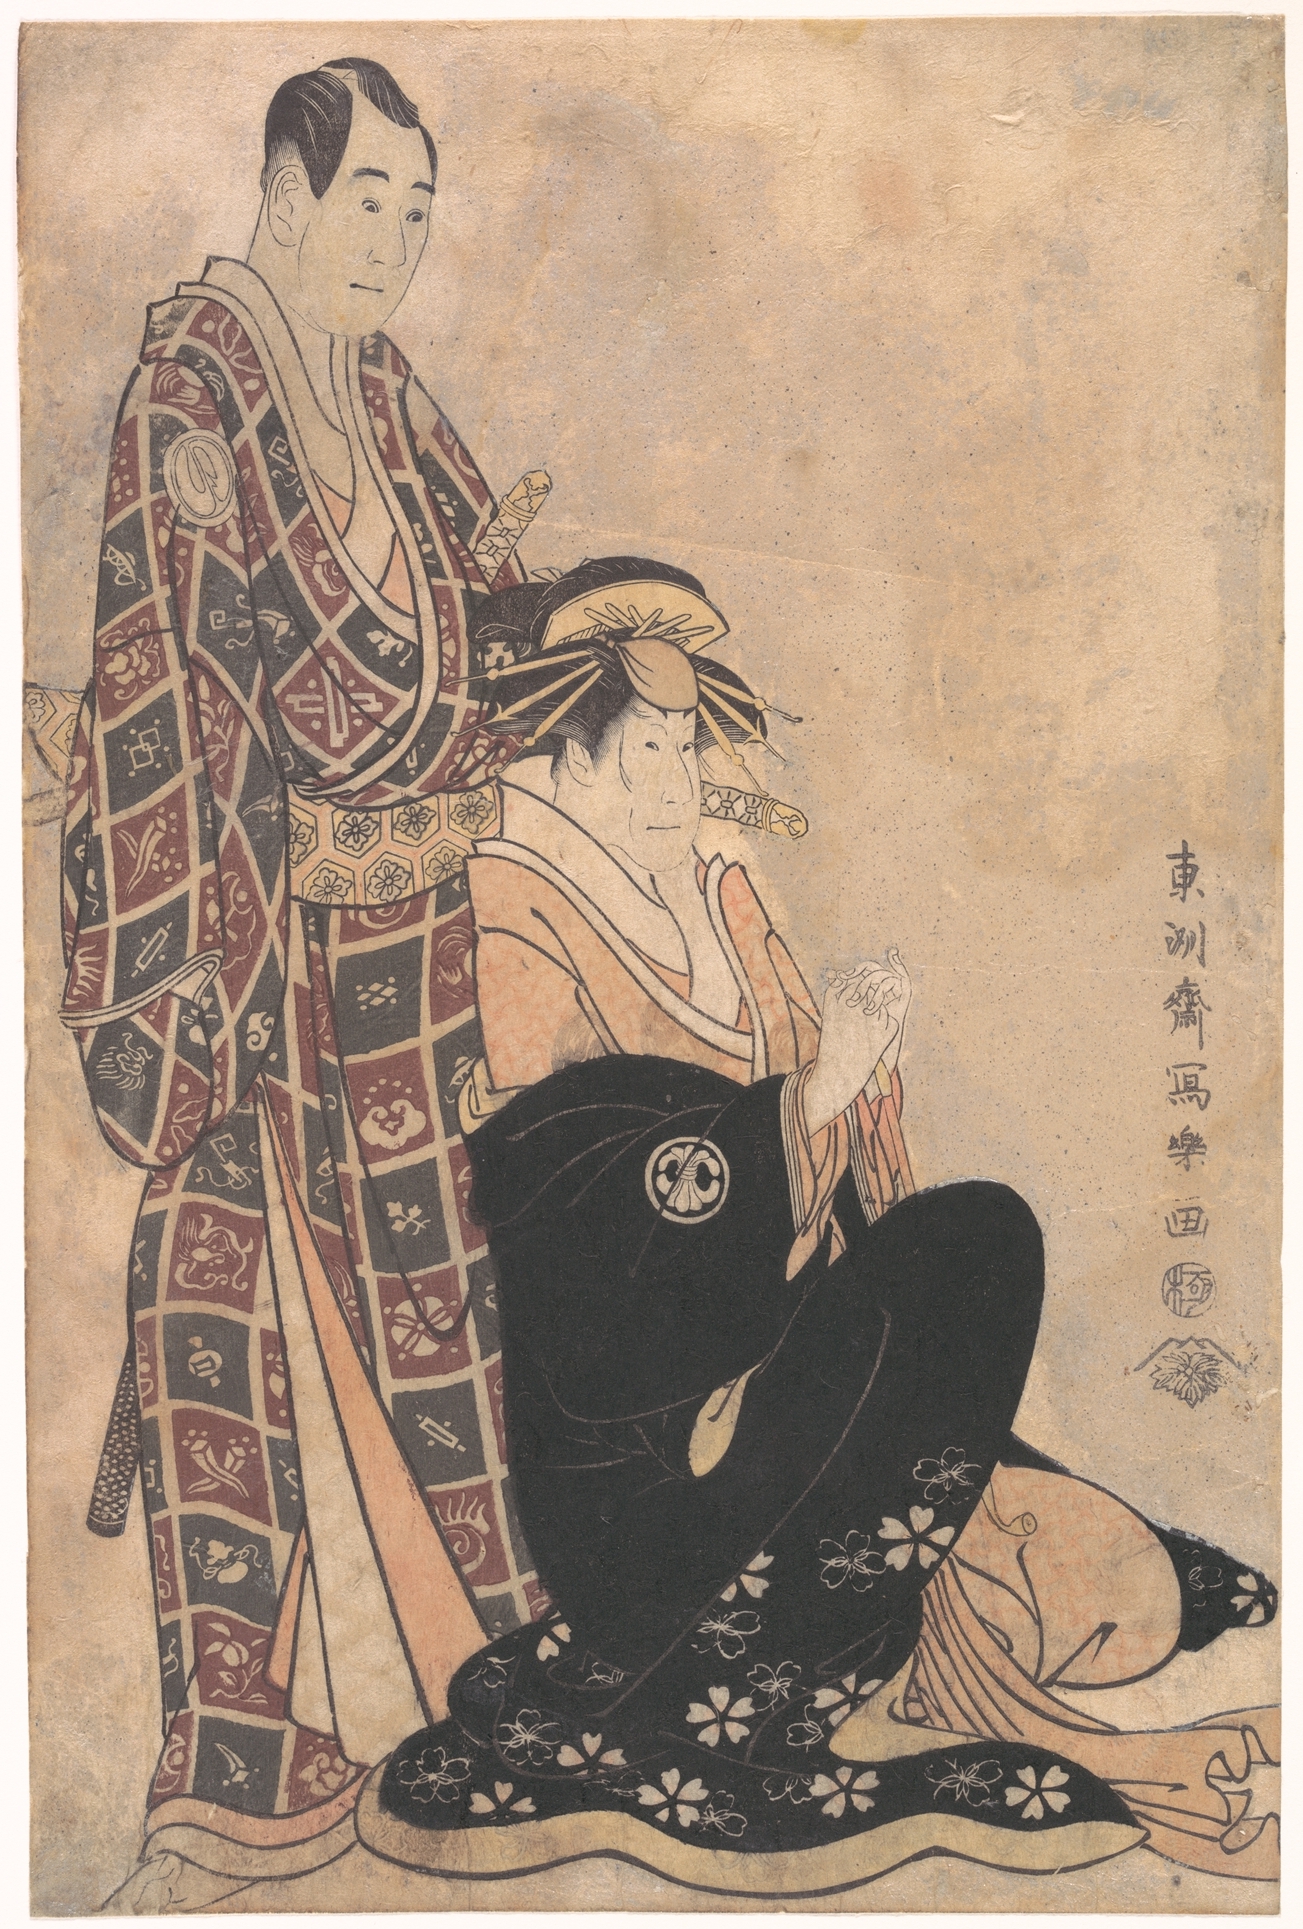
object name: print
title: Sagawa Kikunojo III as the Courtesan Katsuragi,and Sawamura Sojuro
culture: japanese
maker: tōshūsai sharaku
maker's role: artist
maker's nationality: japanese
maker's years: 1794-1795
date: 1794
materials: ink, mica, paper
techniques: woodblock print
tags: men,women,actors